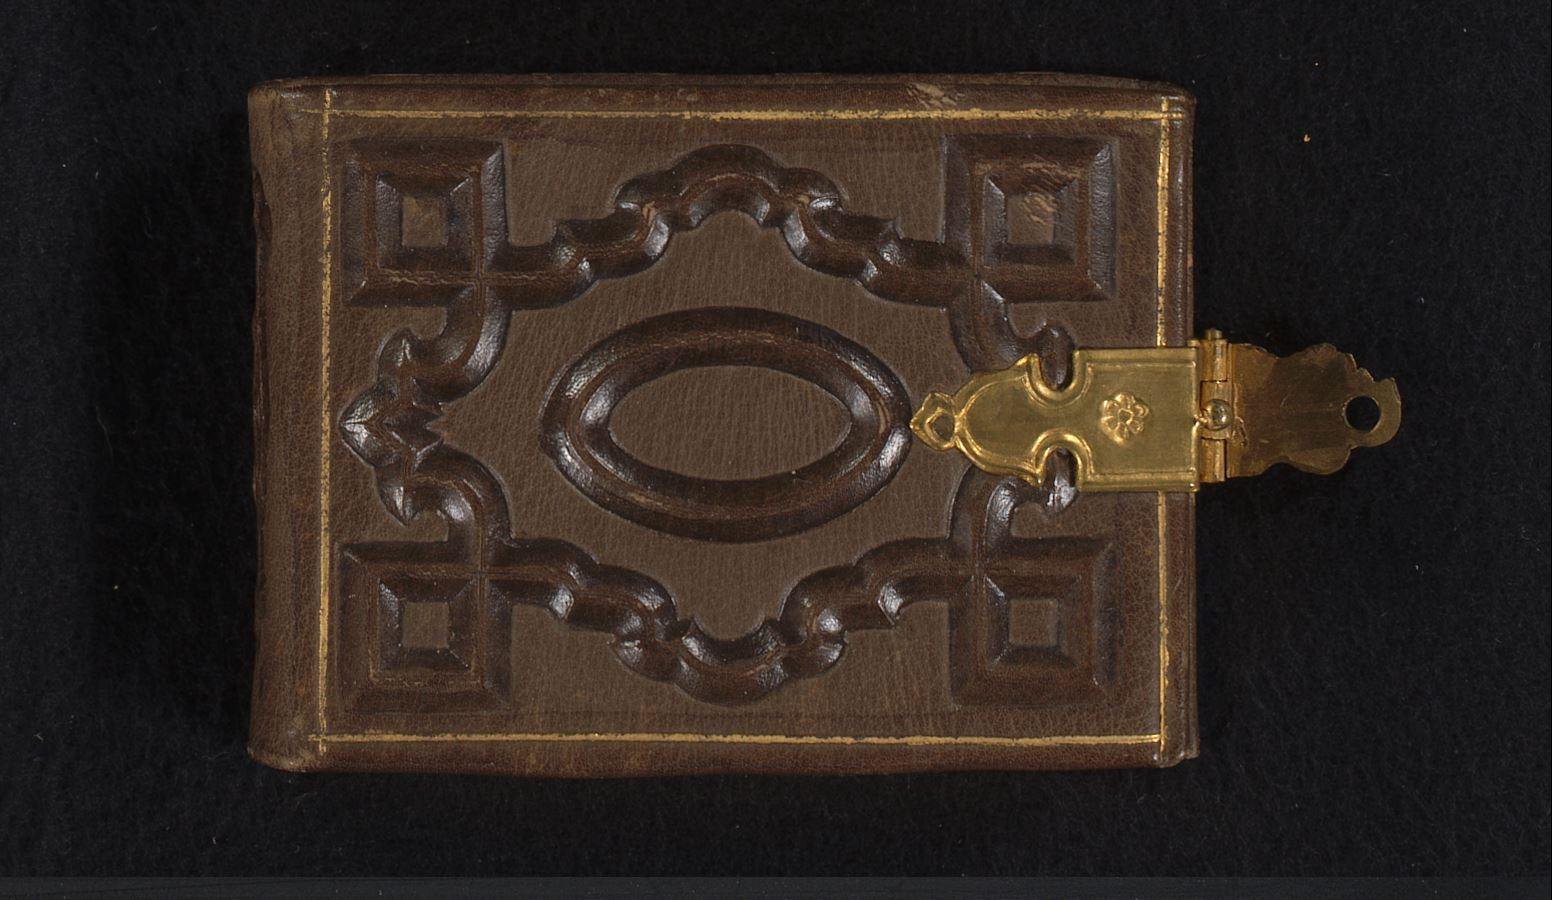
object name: slip in album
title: Miniatuuralbum met portretten en fotoreproducties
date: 1851-1900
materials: brass, cardboard, leather, paper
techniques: albumen print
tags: adult man, anonymous historical person portrayed, anonymous historical person portrayed - bb - woman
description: Miniatuur-insteekalbum met twintig bladen met veertien miniatuurportretten en drie miniatuurfotoreproducties van schilderijen. De fotografen zijn onbekend.